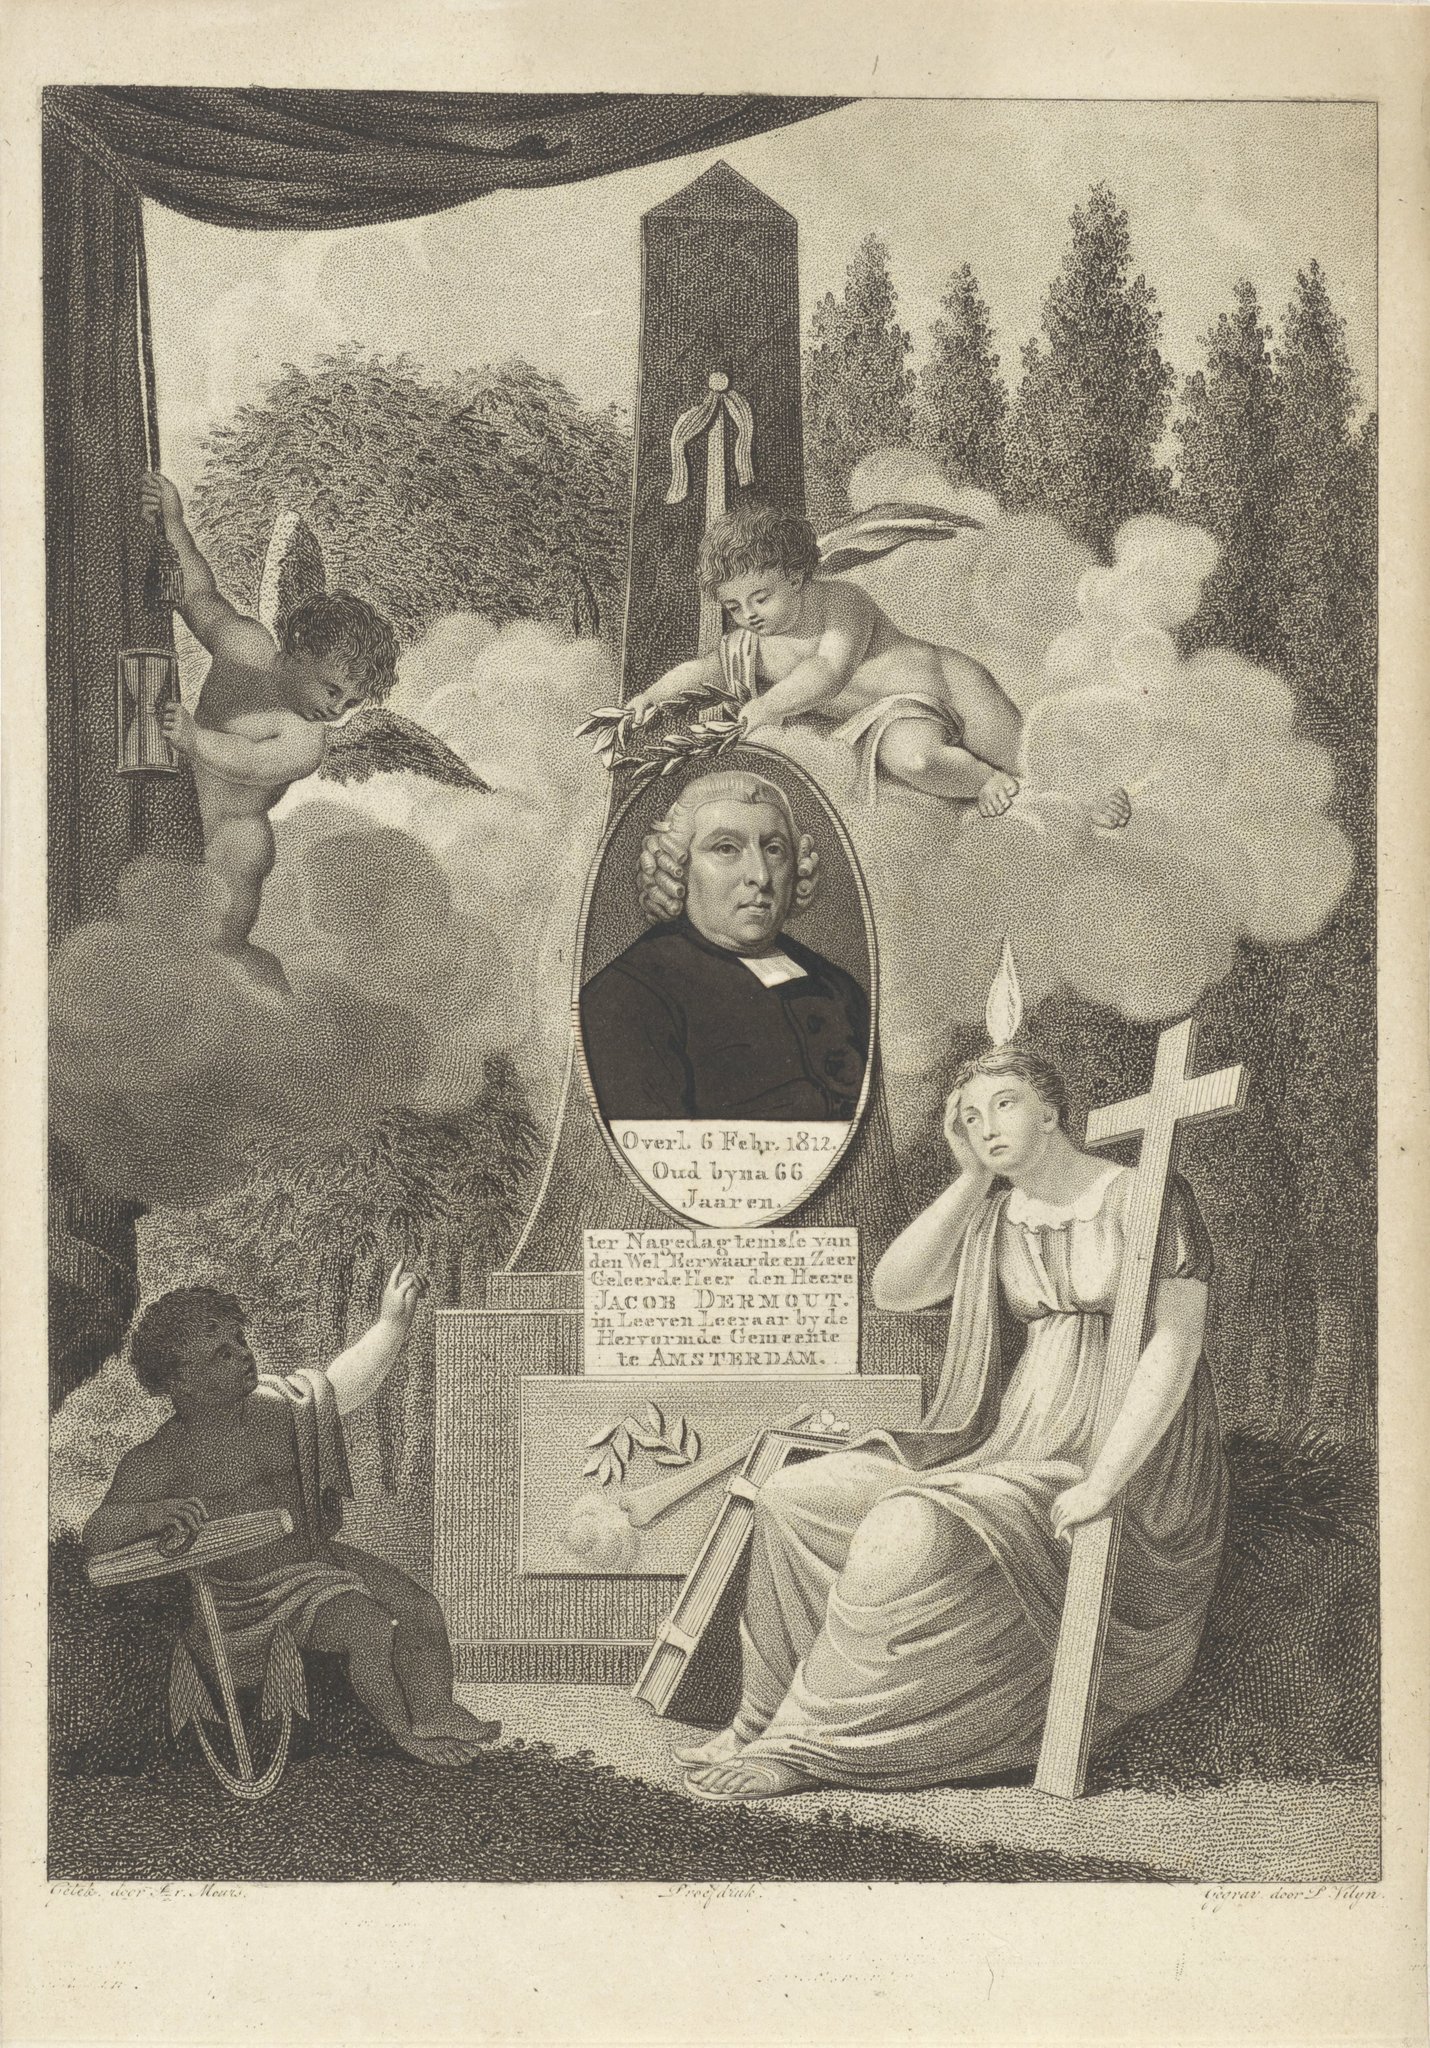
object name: print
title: Allegorisch gedenkteken voor Jacob Dermout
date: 1812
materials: paper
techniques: engraving, etching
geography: netherlands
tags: crucifix ~ personal devotion (+ variant), other memorial structures, cupids: 'amores', 'amoretti', 'putti'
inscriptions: collector's mark: Lugt 2228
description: Allegorisch gedenkteken voor Jacob Dermout, predikant in Amsterdam. Een allegorische vrouwenfiguur met een vlam op het hoofd en een crucifix aan de voet van het monument, waarop het portret van Dermout in een medaillon. Daaromheen drie putti met anker, zandloper en lauwerkrans.